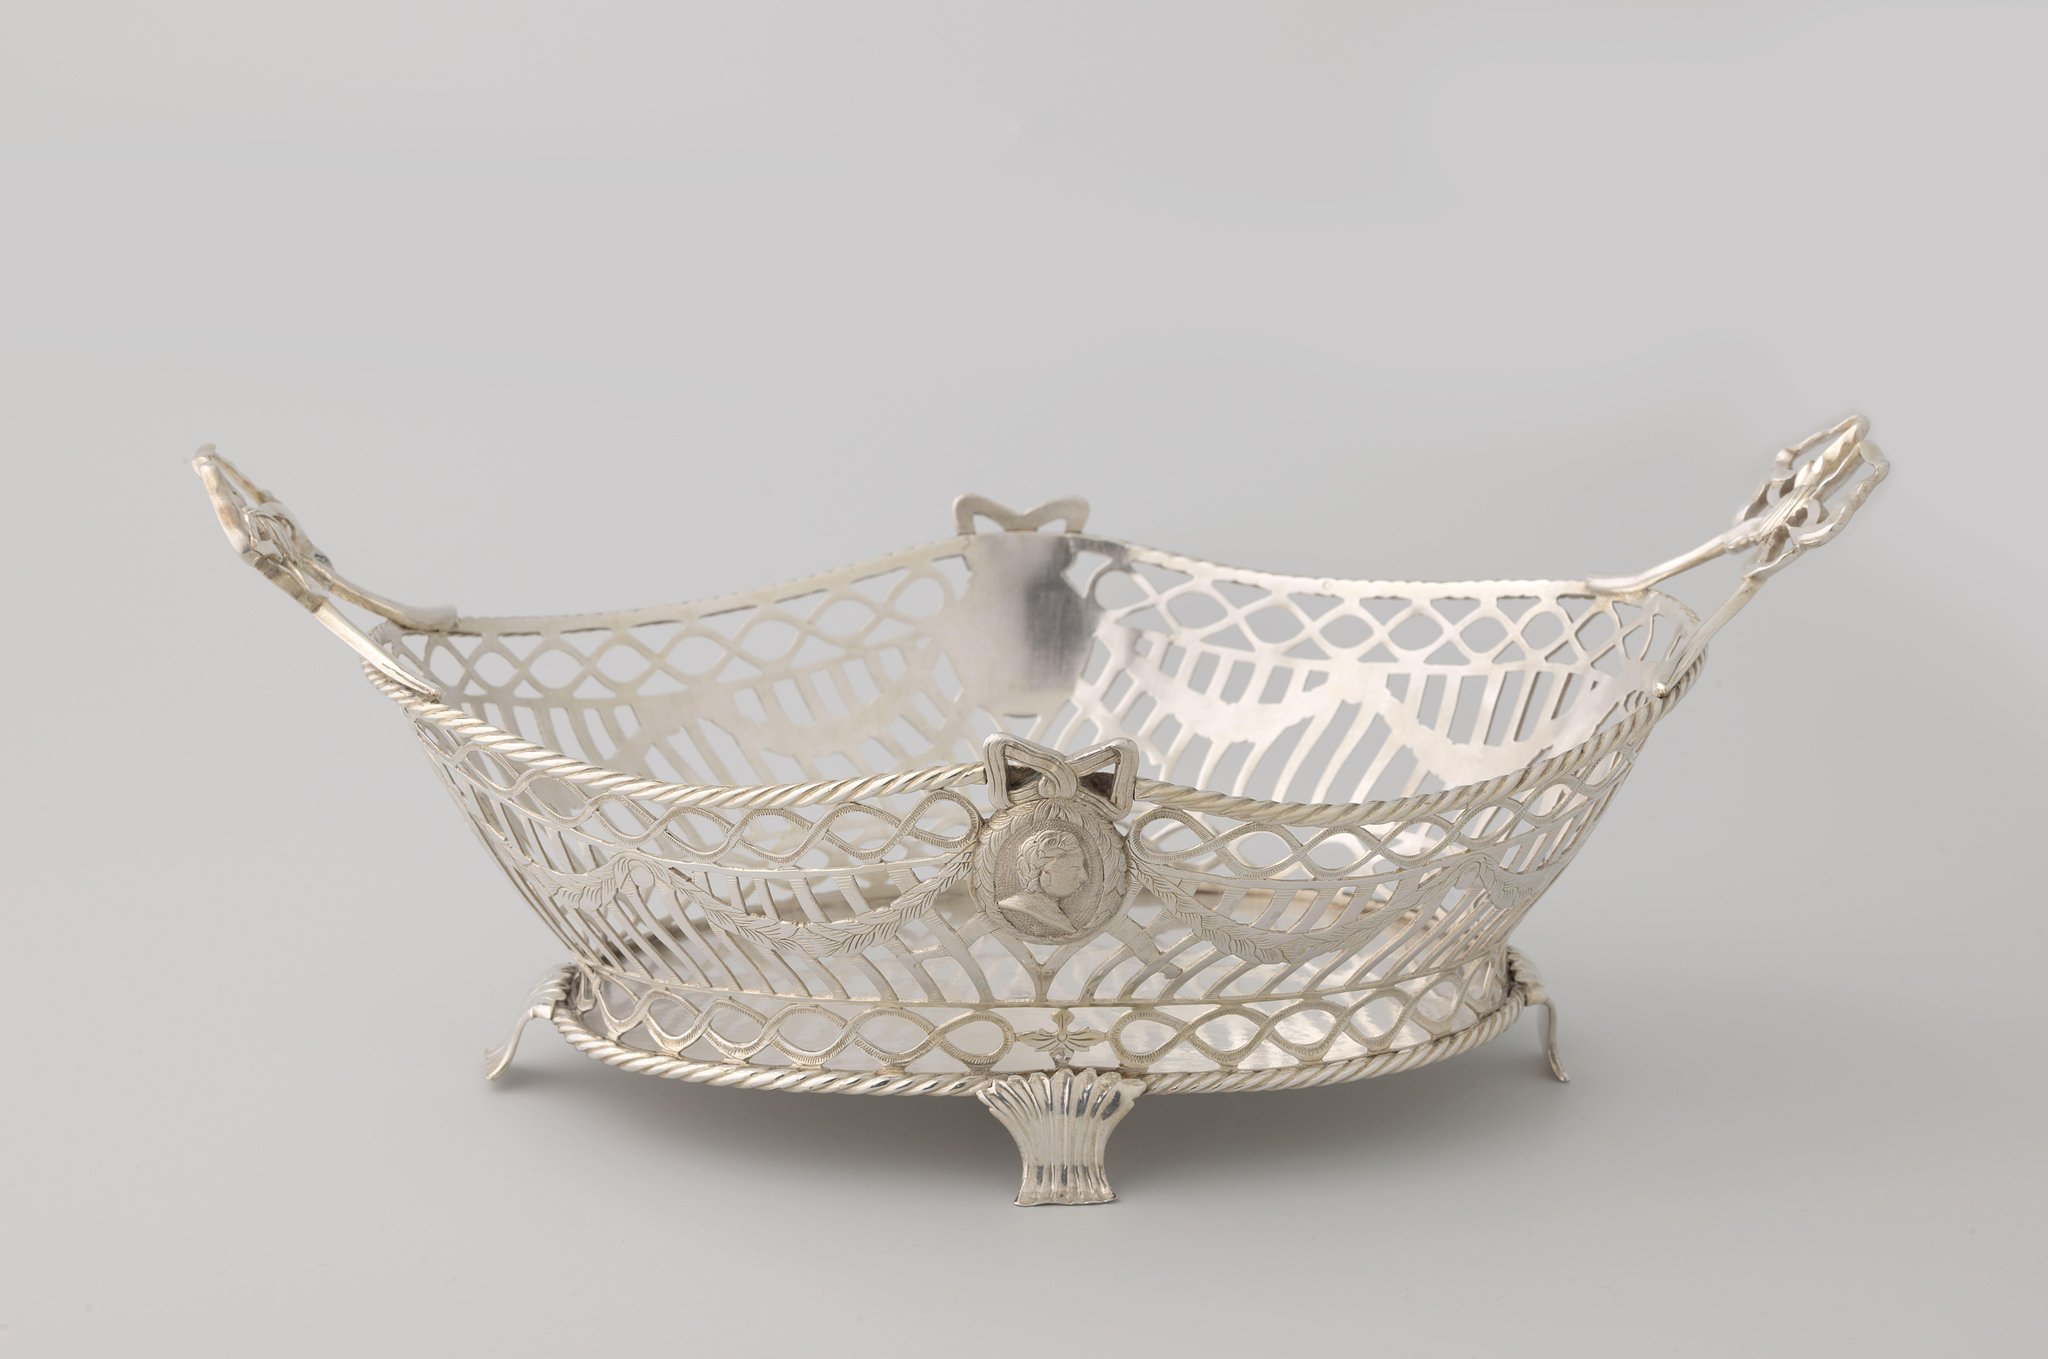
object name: bread basket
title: Broodmand met opengewerkte gewelfde wand met ovale medaillons met strikversiering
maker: Anonymous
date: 1780-1810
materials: silver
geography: indonesia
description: Ovale broodmand van zilver, op vier gebogen, ingesnoerde, geribde poten. De gewelfde rand is opengewerkt. In het midden van voor- en achterzijde is een ovaal, aan een strik opgehangen medaillon opgelegd.